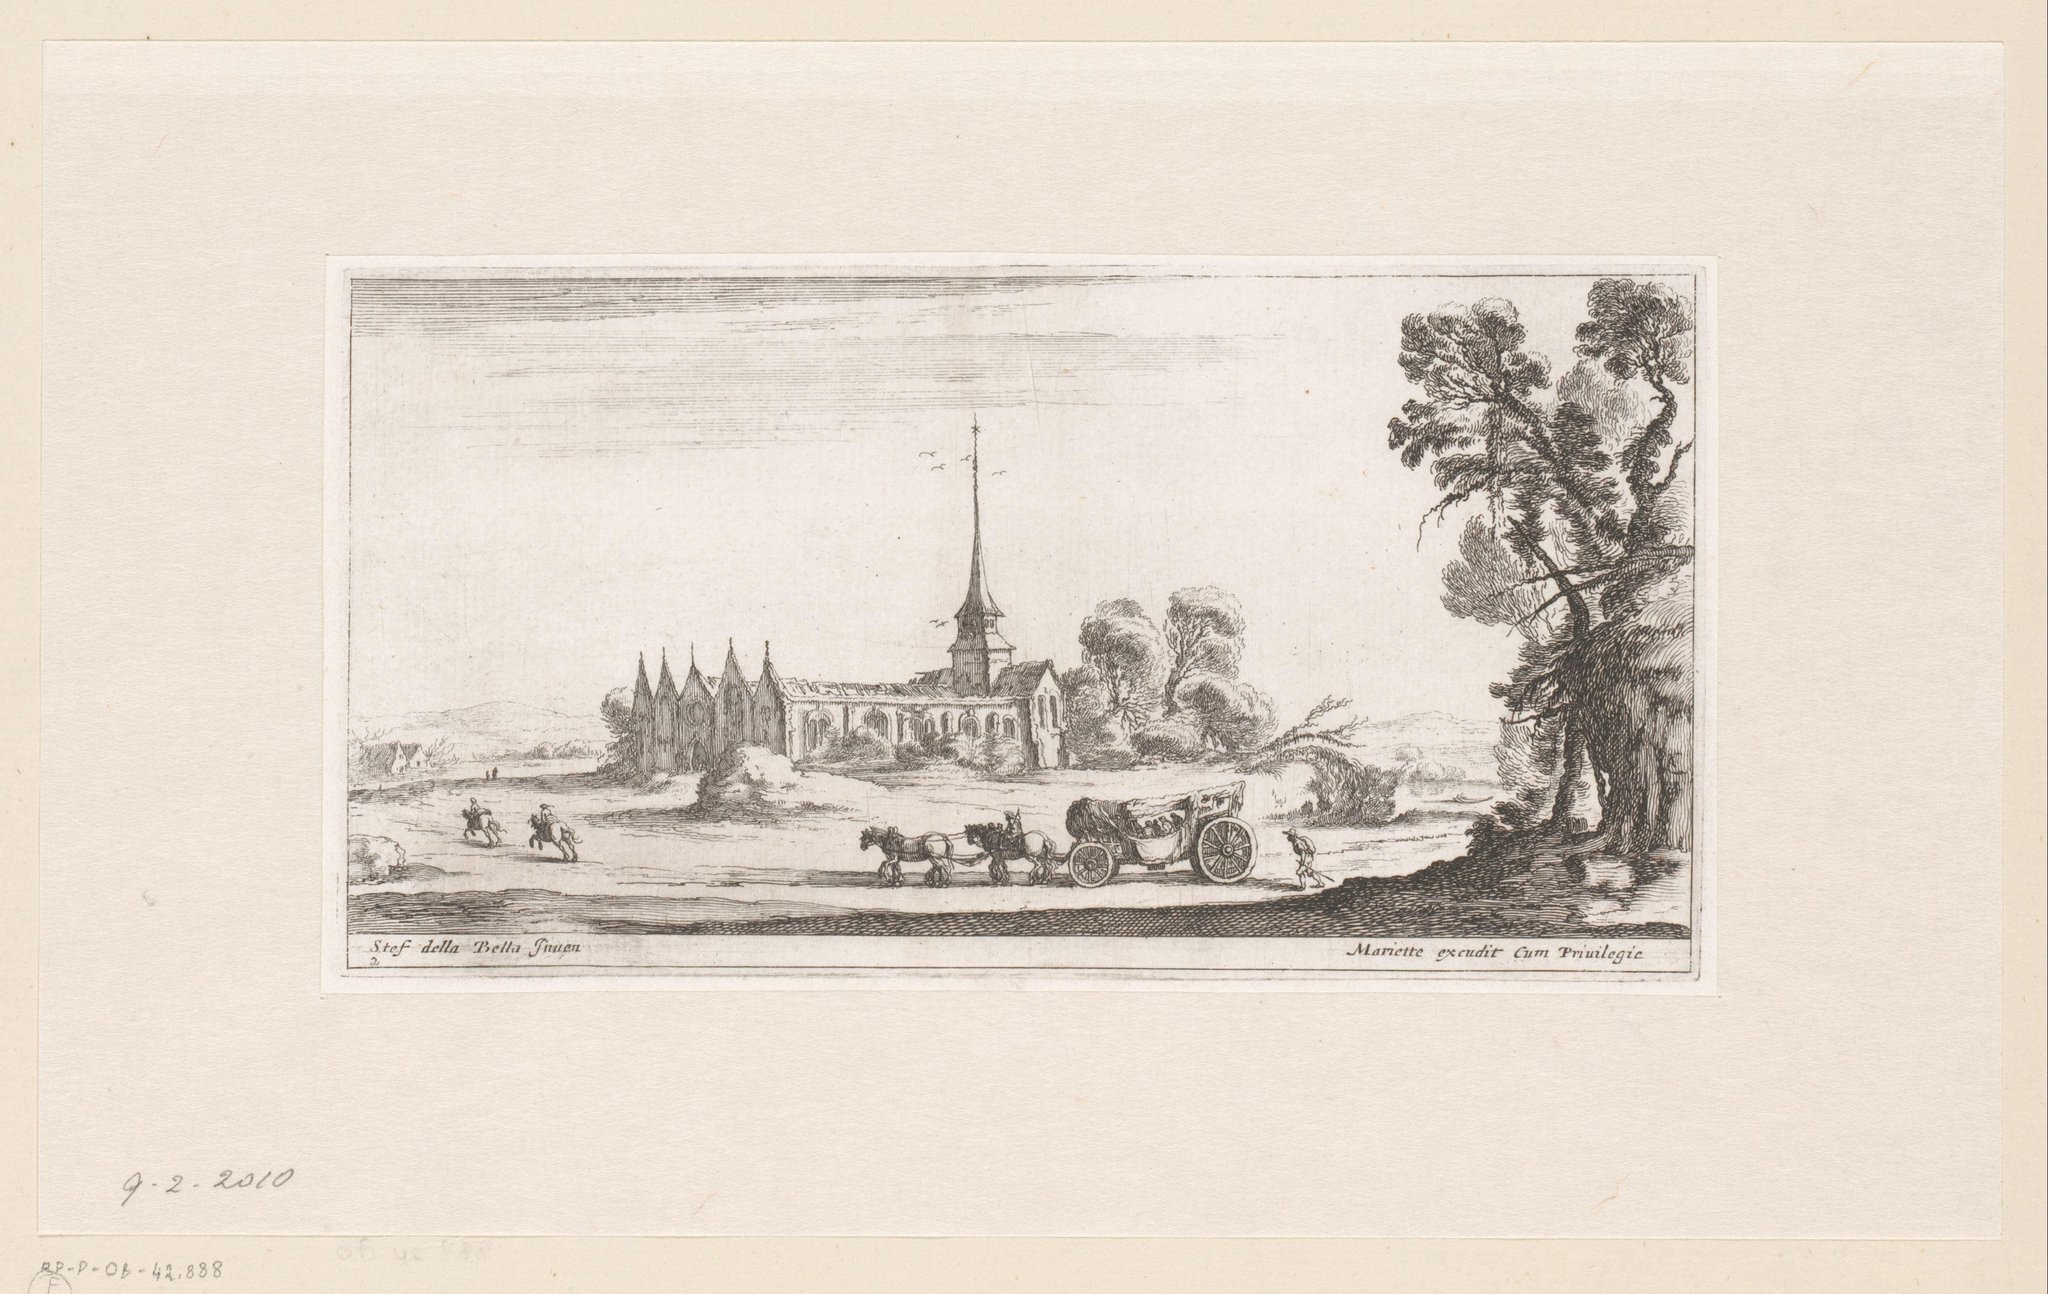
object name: print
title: Vier landschappen waaronder zeezichten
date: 1643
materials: paper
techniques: etching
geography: paris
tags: animal traction, animal-drawn vehicle (carriage etc.), landscapes, church (exterior)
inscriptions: collector's mark: Lugt 240